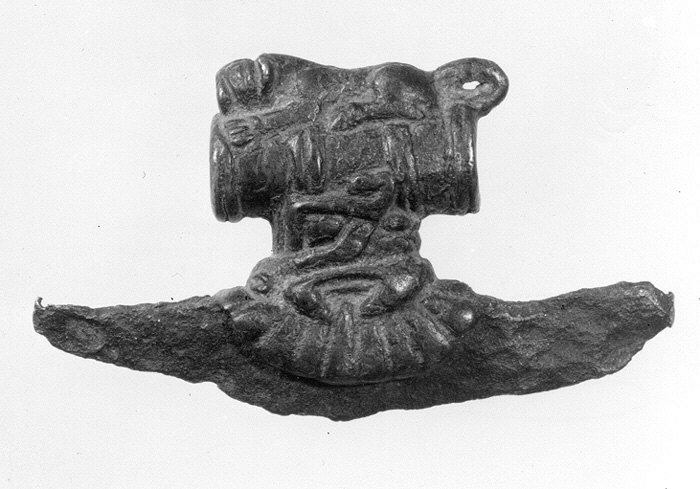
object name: axe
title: Crescent-shaped axe head with an iron blade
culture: iranian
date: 1000-668 BCE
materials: bronze, iron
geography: iran, probably from luristan